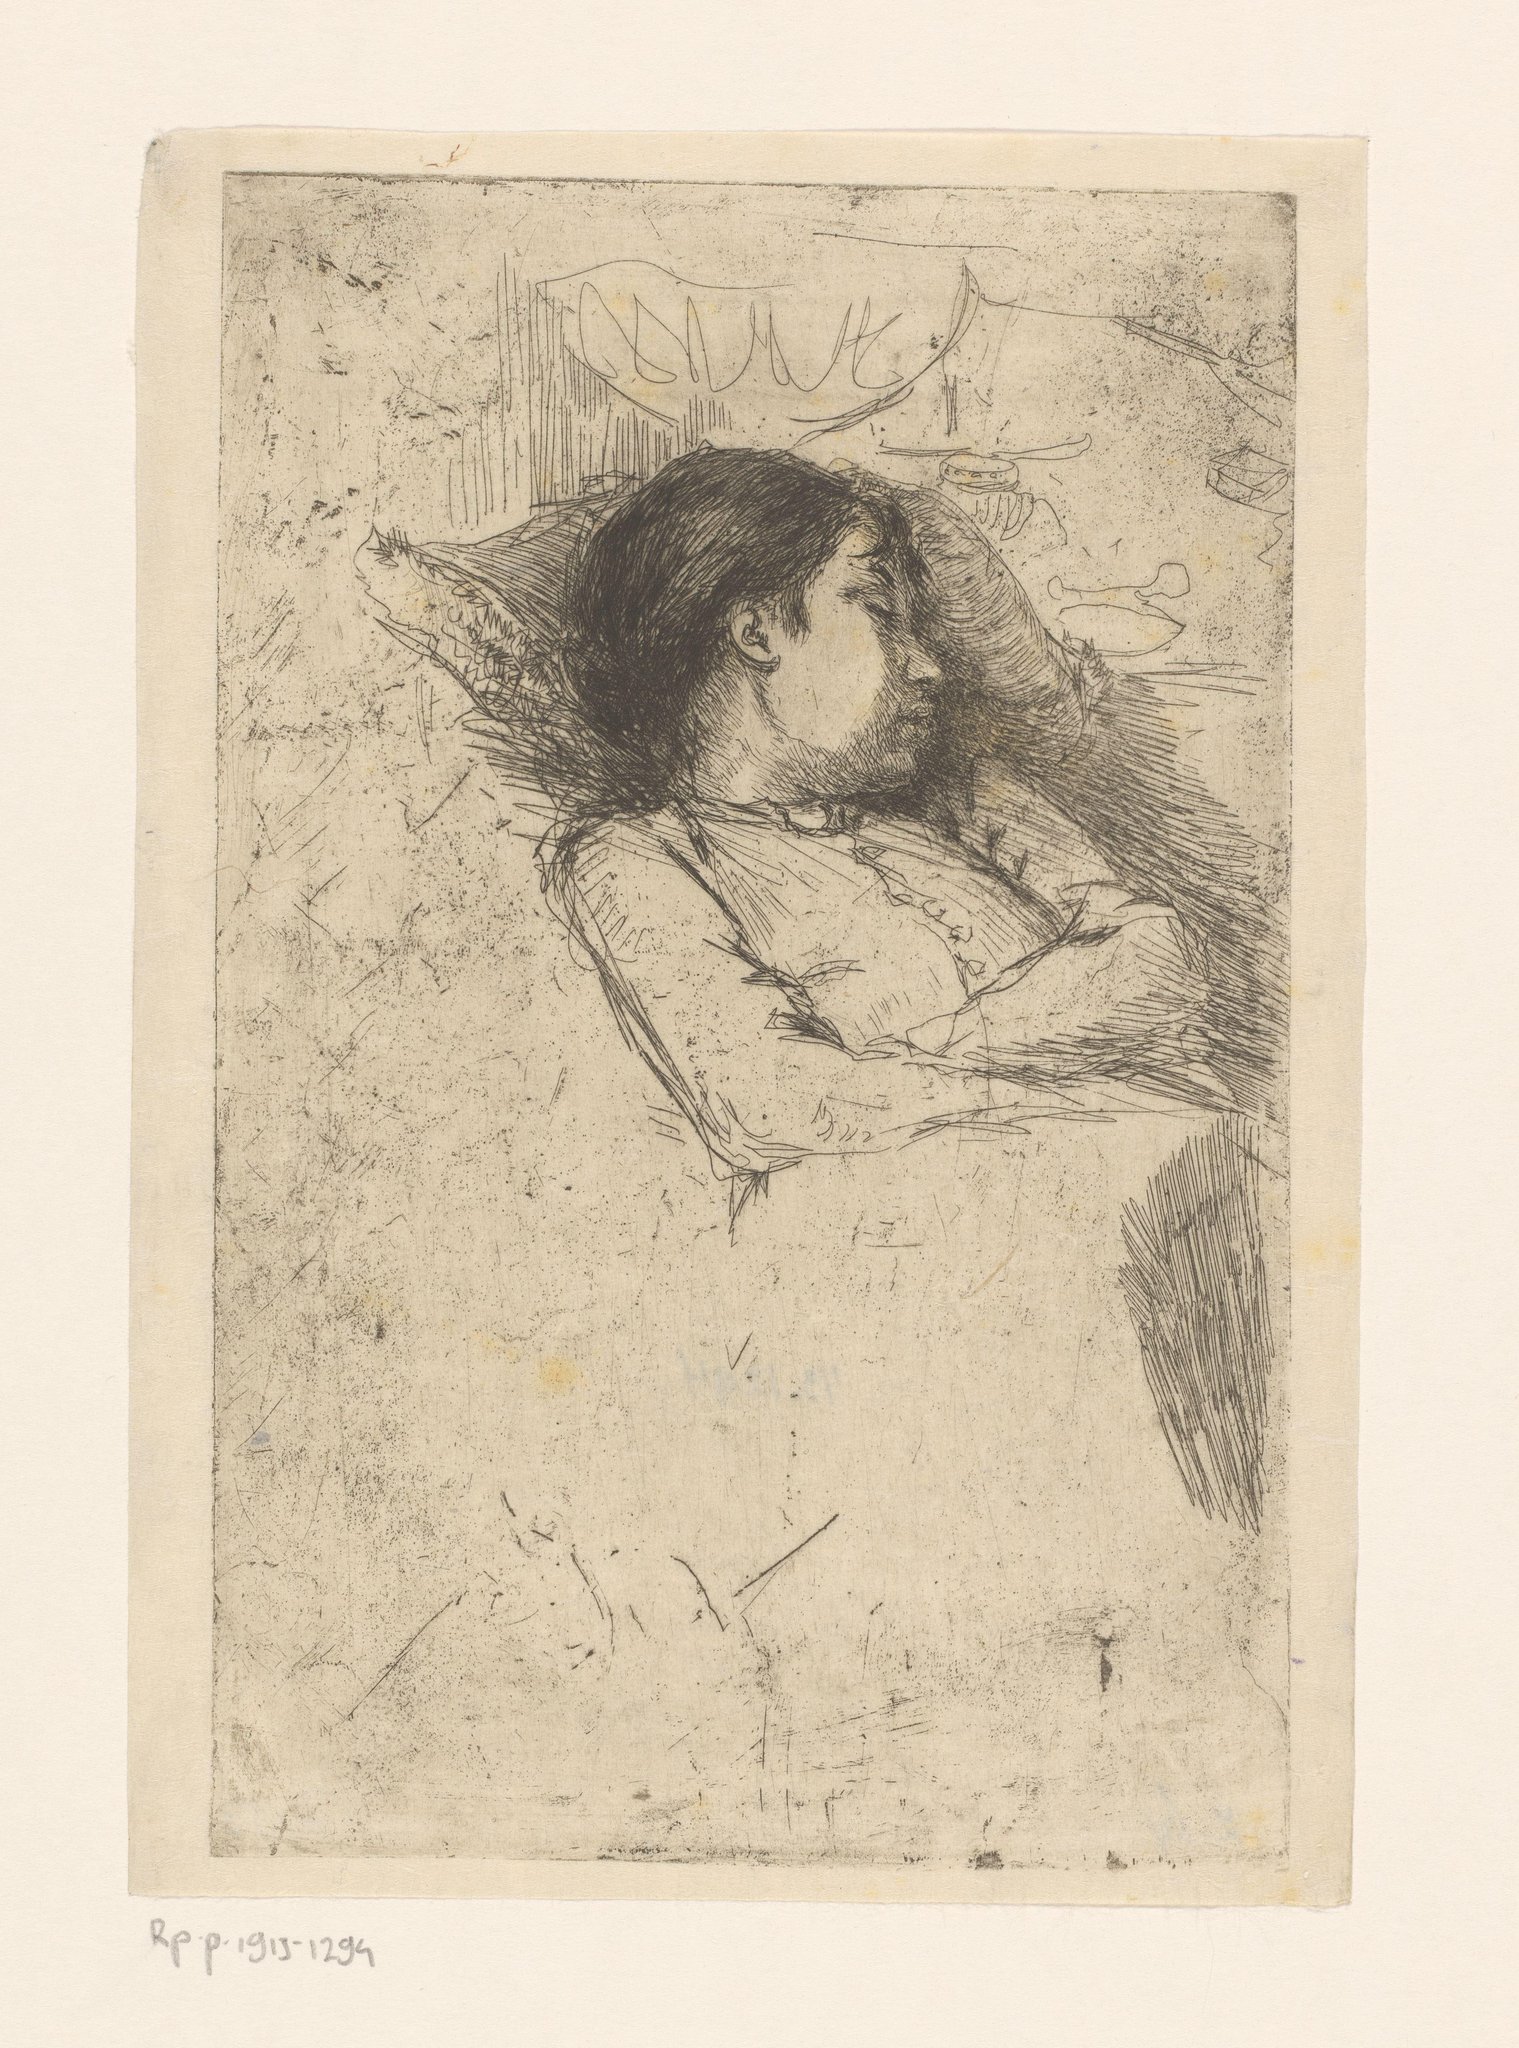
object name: print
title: Sommeil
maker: philip zilcken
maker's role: draughtsman, painter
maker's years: 1857-1930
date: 1867-1890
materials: paper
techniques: drypoint, etching, intaglio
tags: girl (child between toddler and youth), sleeping in bed